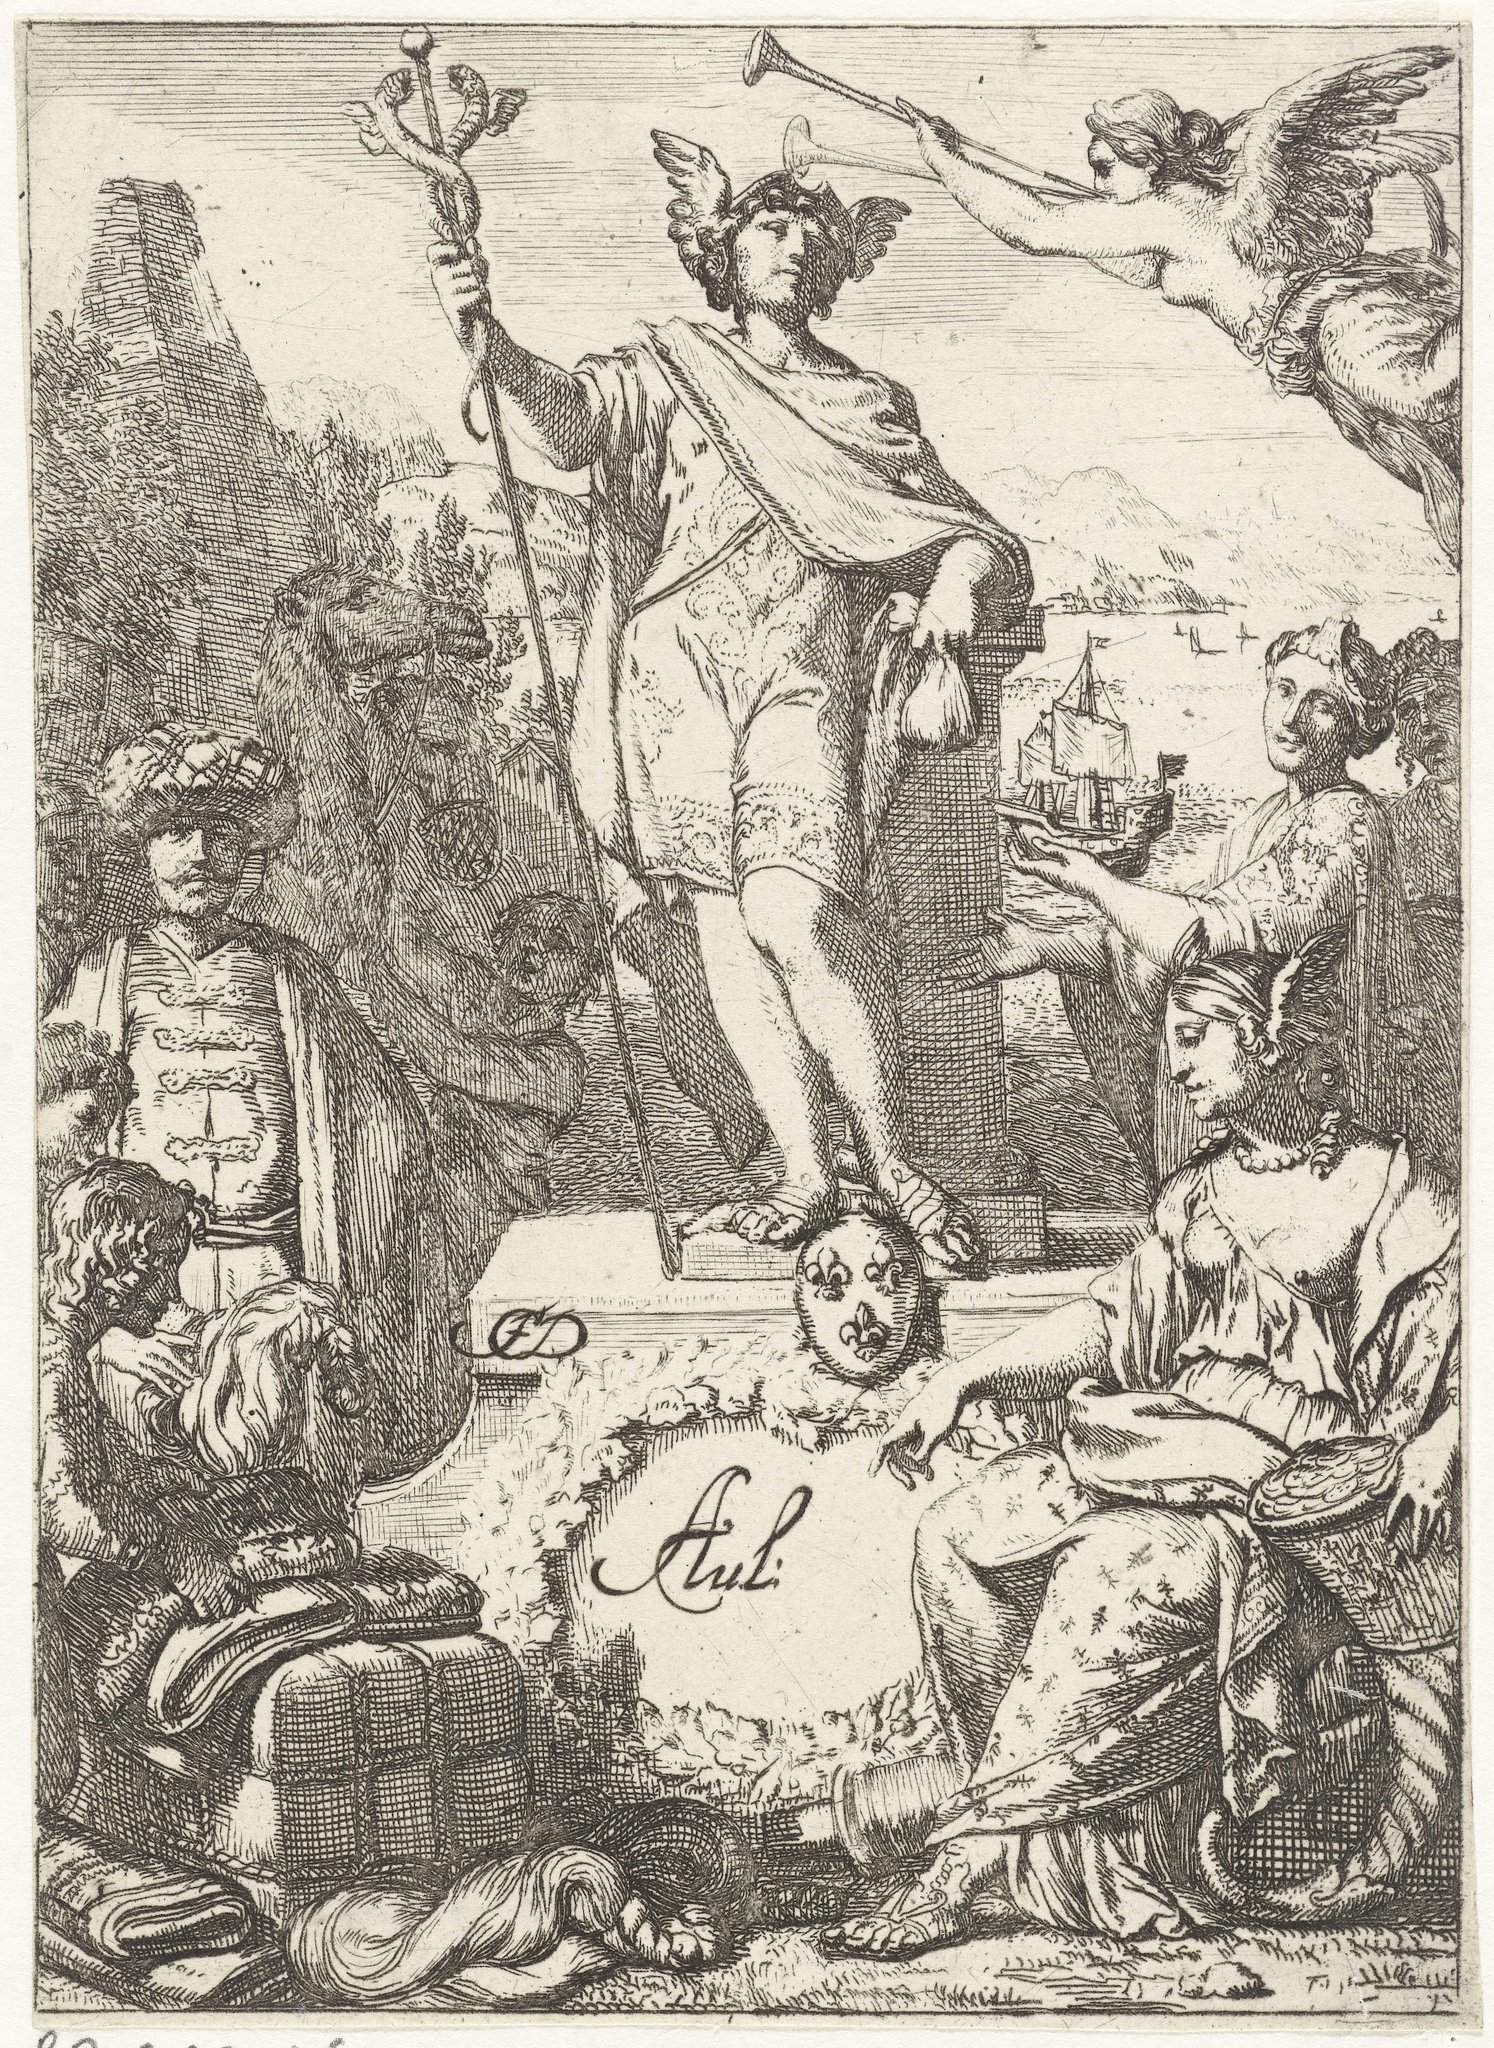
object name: print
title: Allegorie op de handel met Mercurius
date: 1600-1699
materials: paper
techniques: engraving, etching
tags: hoofed animals: camel, (story of) mercury (hermes), allegory of trade; 'commertio della vita humana' (ripa), labour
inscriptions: collector's mark: Lugt 240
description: Mercurius staat op een voetstuk dat versierd is met het wapen van Frankrijk, de bazuin blazende Faam vliegt naast zijn hoofd. Op de voorgrond zit rechts de personifictie van Arbeid en Vlijt, gehuld in een kleed bezet met mieren. Ze wijst op een met krans omgeven ovaal met het opschrift "Aul", in haar linkerhand houdt ze een met geld gevulde hoorn vast. Links staat een Oosterse koopman bij stoffen en verpakte handelswaar, achter hem wachten twee kamelen.